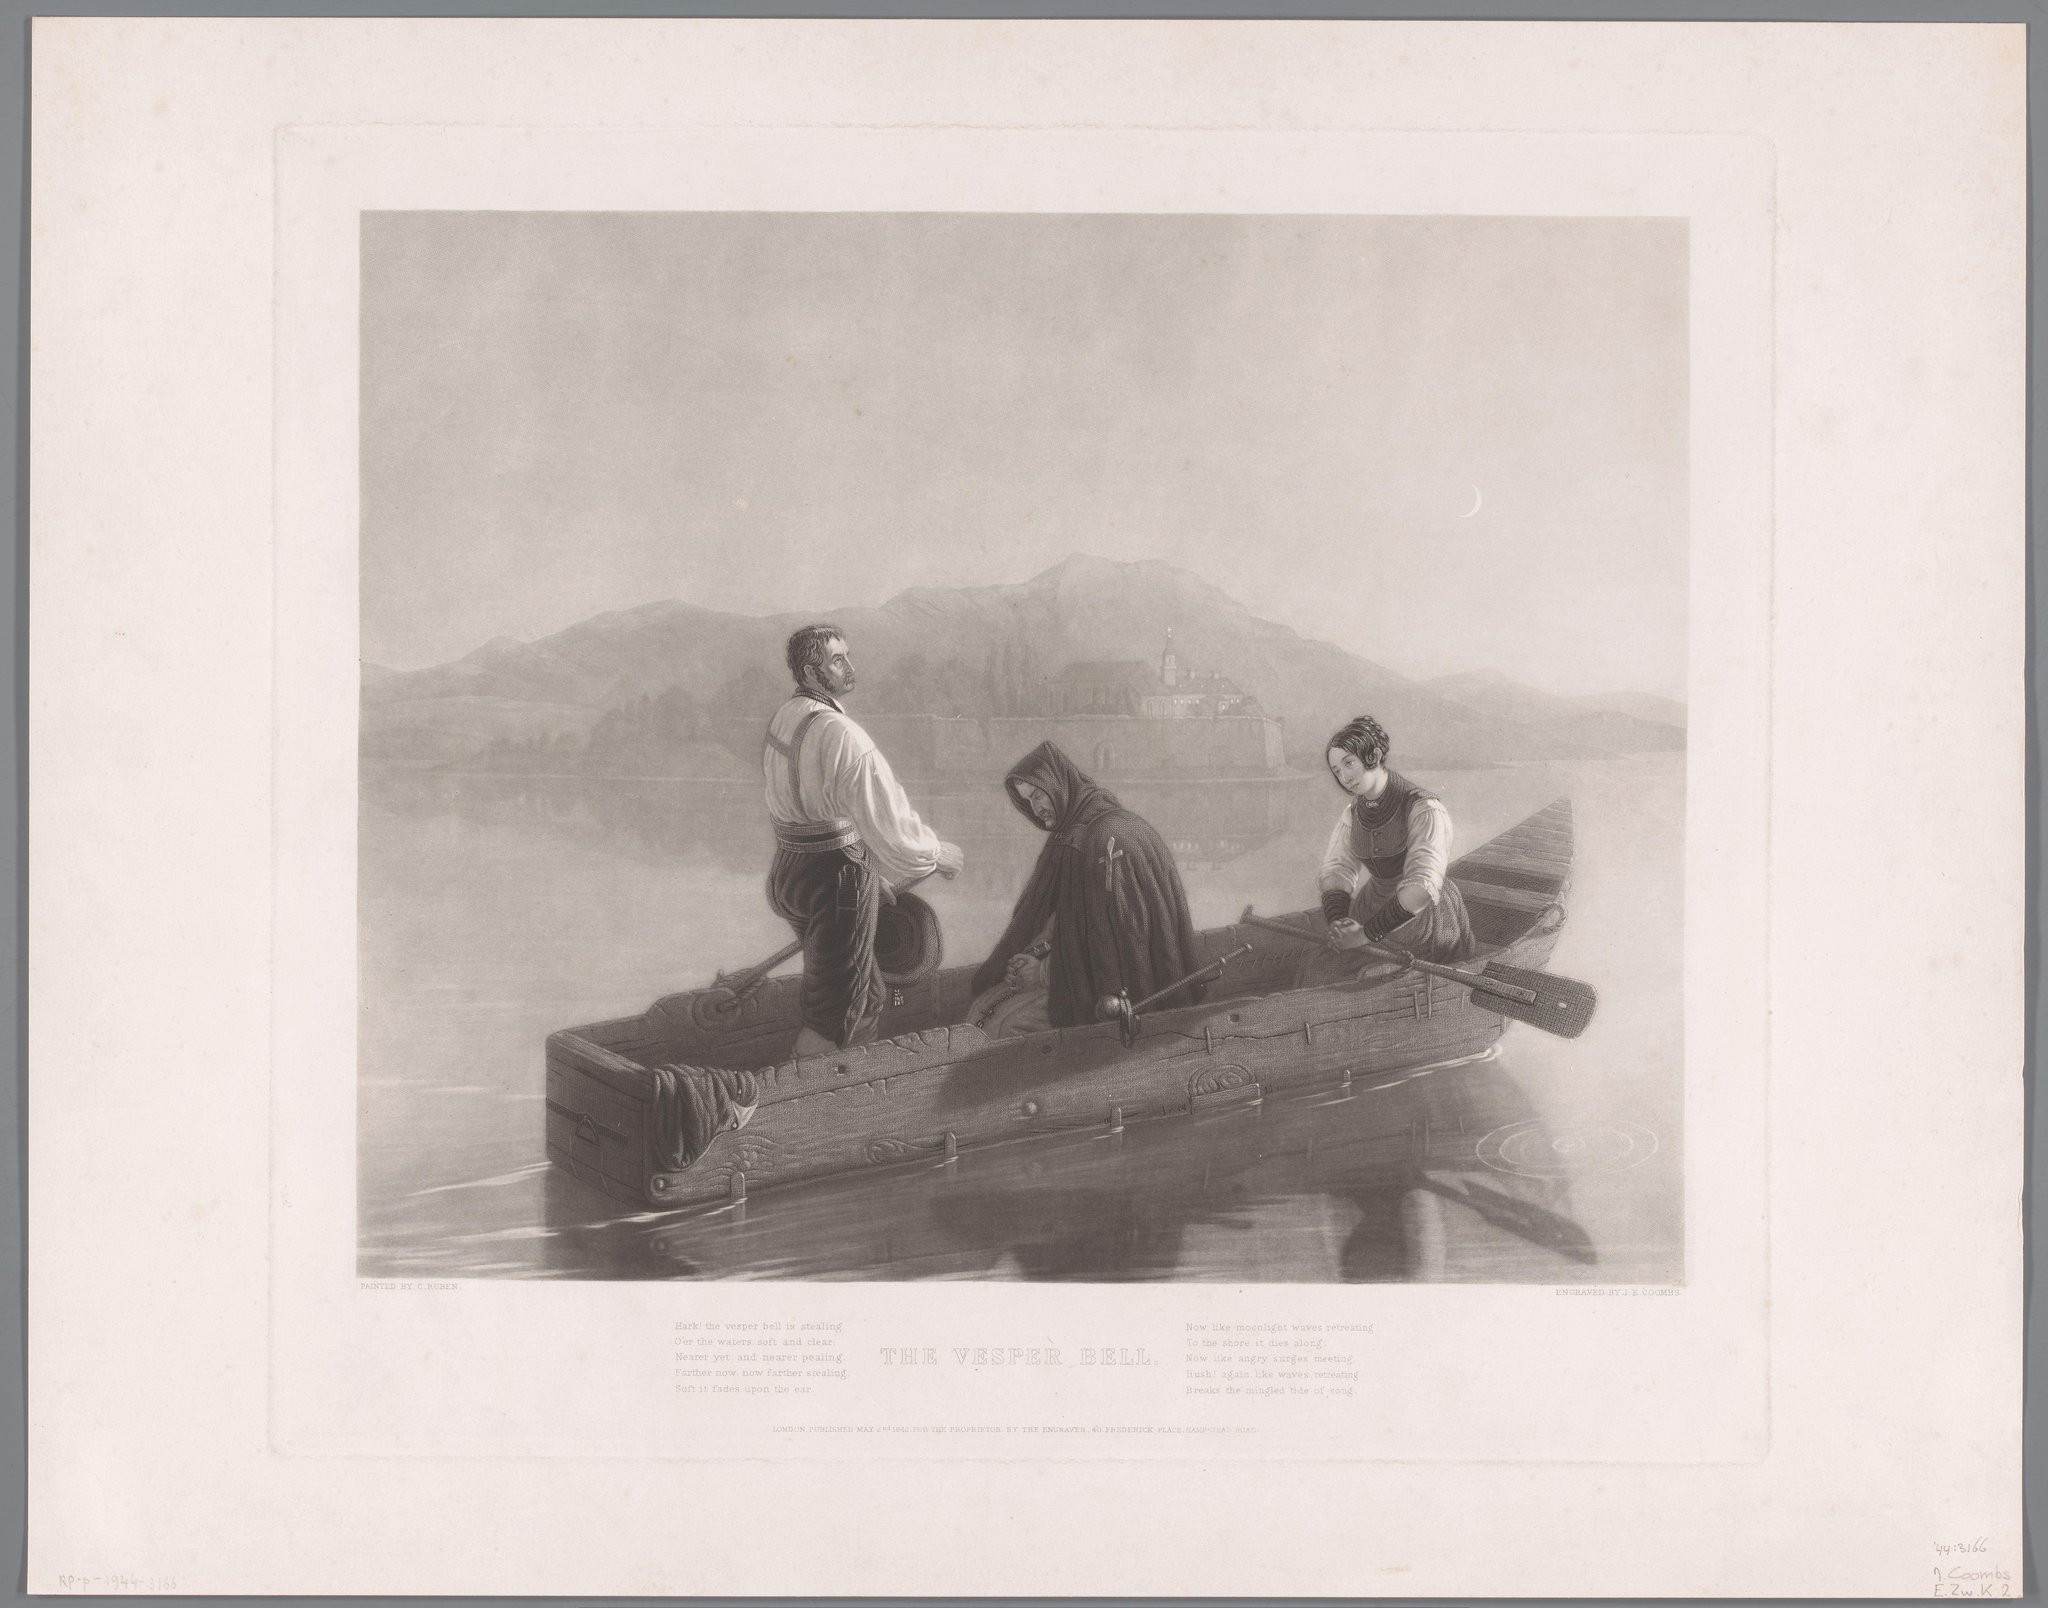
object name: print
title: Drie figuren in een roeiboot op een meer in de avond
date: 1842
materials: paper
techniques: etching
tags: evening, rowing-boat, canoe, etc., lake (+ landscape with figures, staffage)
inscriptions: collector's mark: Lugt 2228